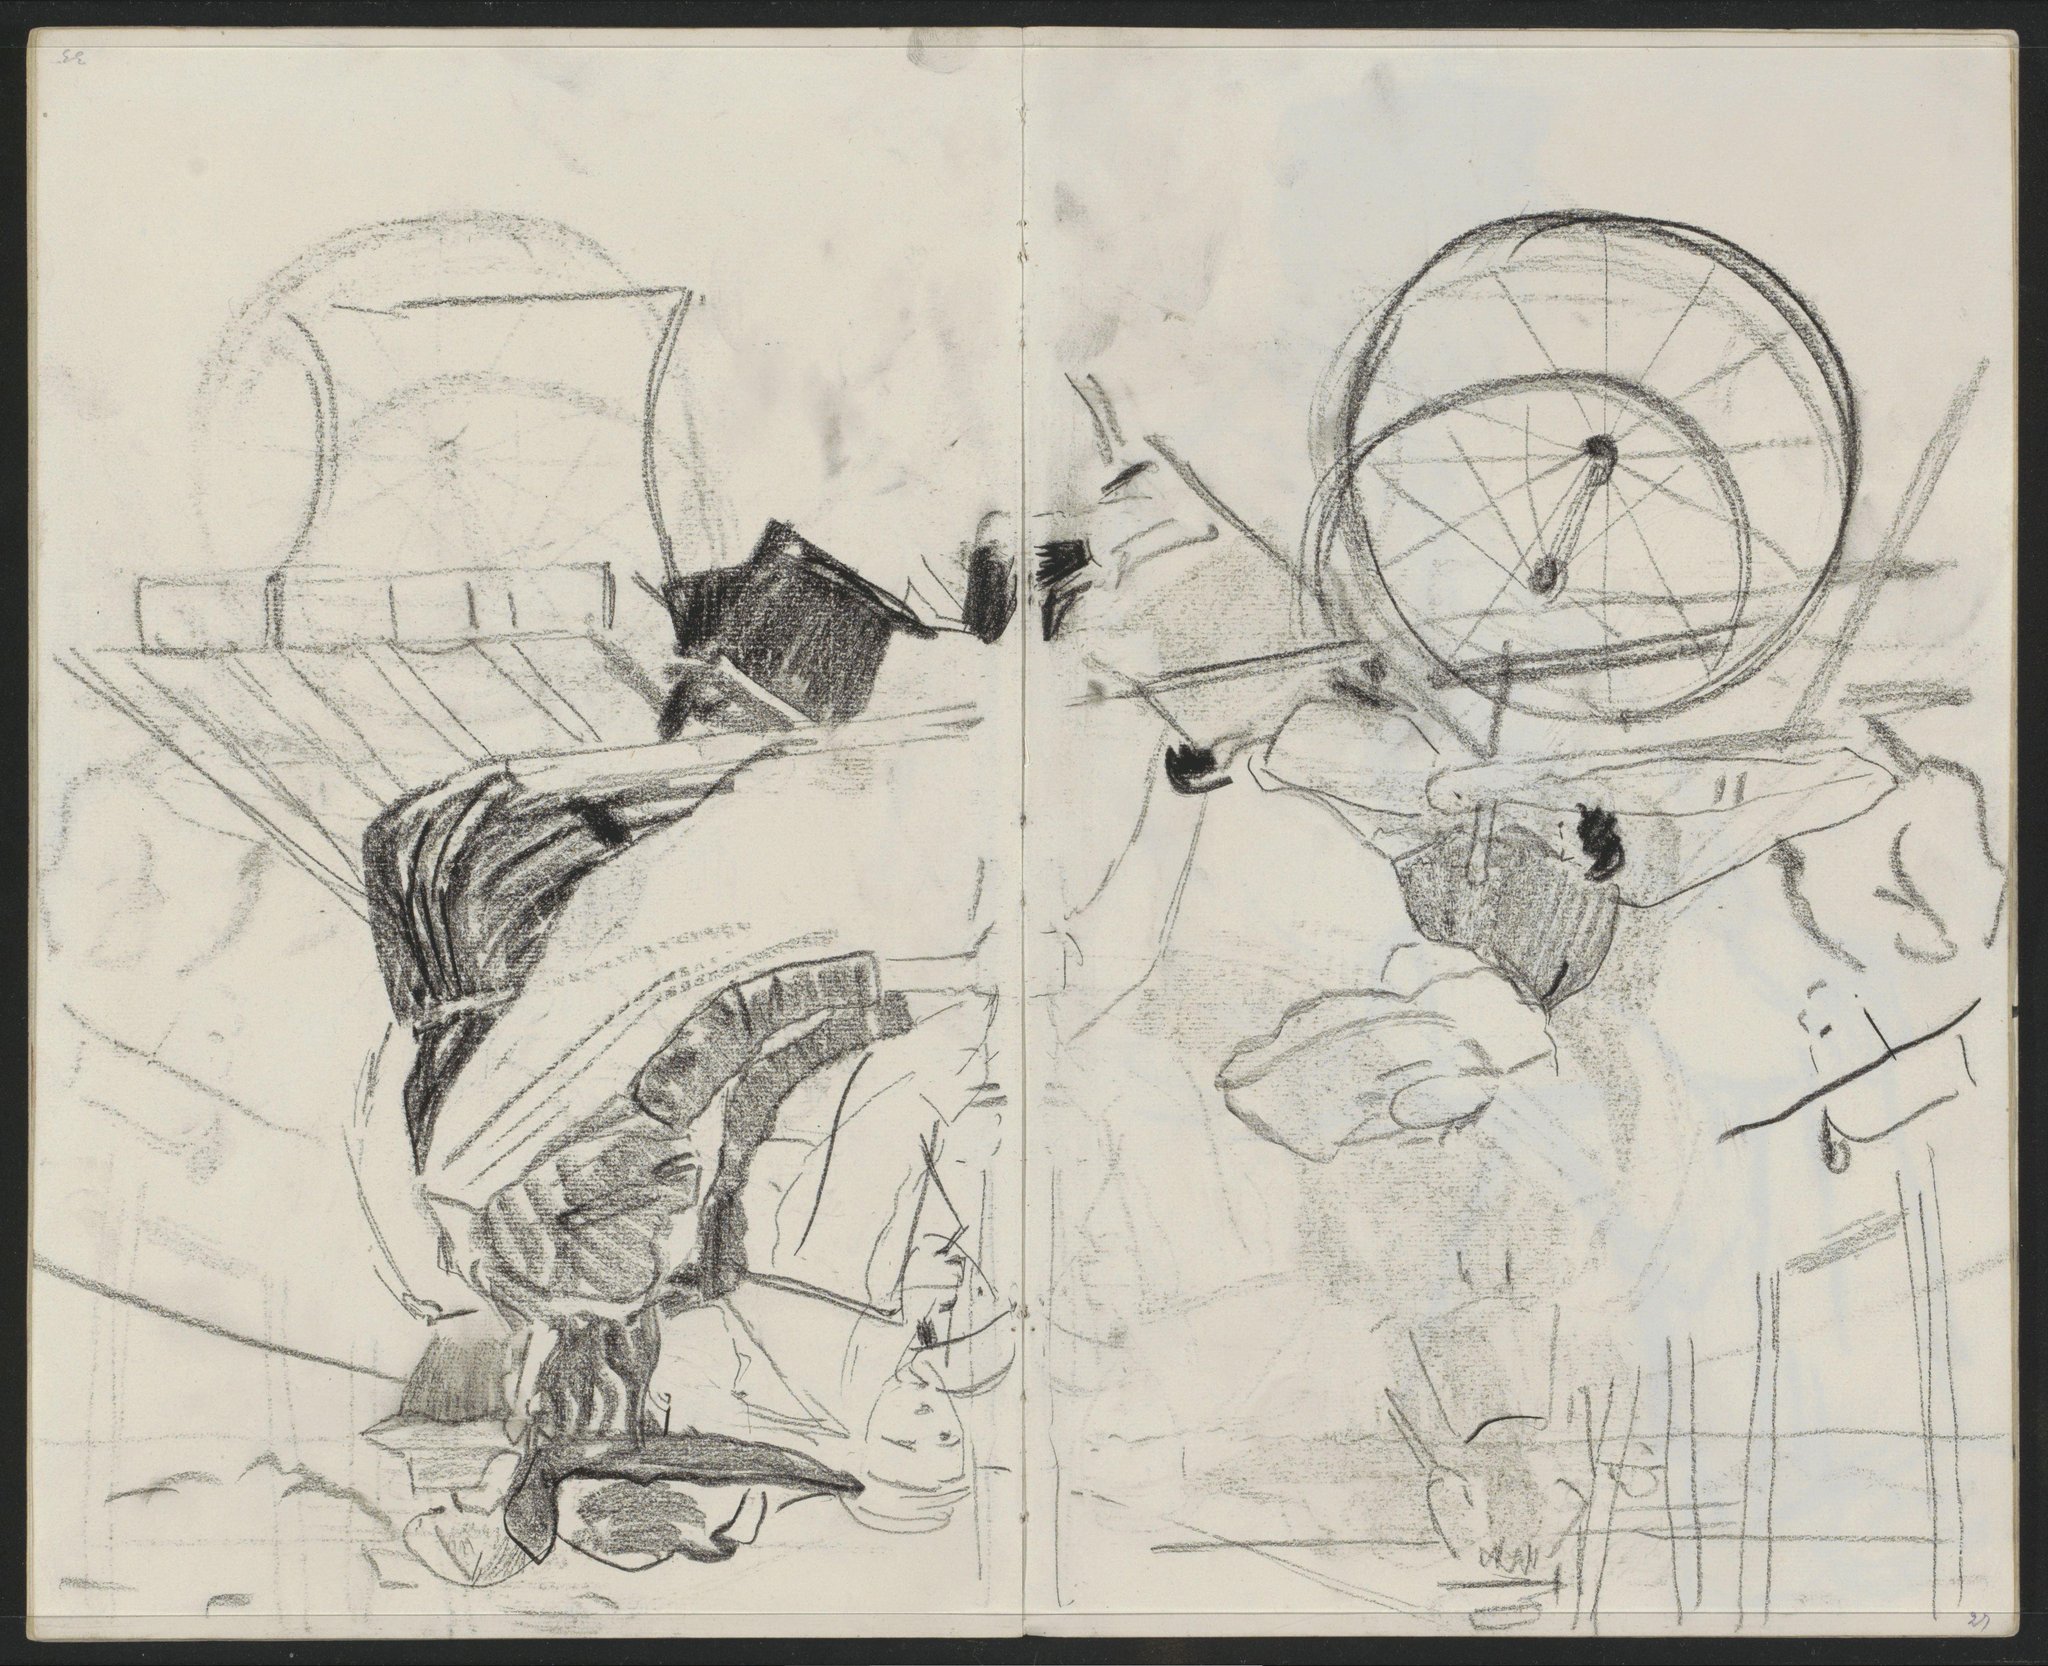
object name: sketchbook leaf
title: Vrouwen met kinderen in het Oosterpark te Amsterdam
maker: isaac israels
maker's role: draughtsman, painter, print maker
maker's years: 1865-1934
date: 1875-1934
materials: chalk, paper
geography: amsterdam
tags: park, mother and child(ren), woman and child(ren) (family group)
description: Vooraan een vrouw op een bank met twee kinderen op een kar. Blad 26 verso en blad 27 recto uit schetsboek XI met 30 bladen.